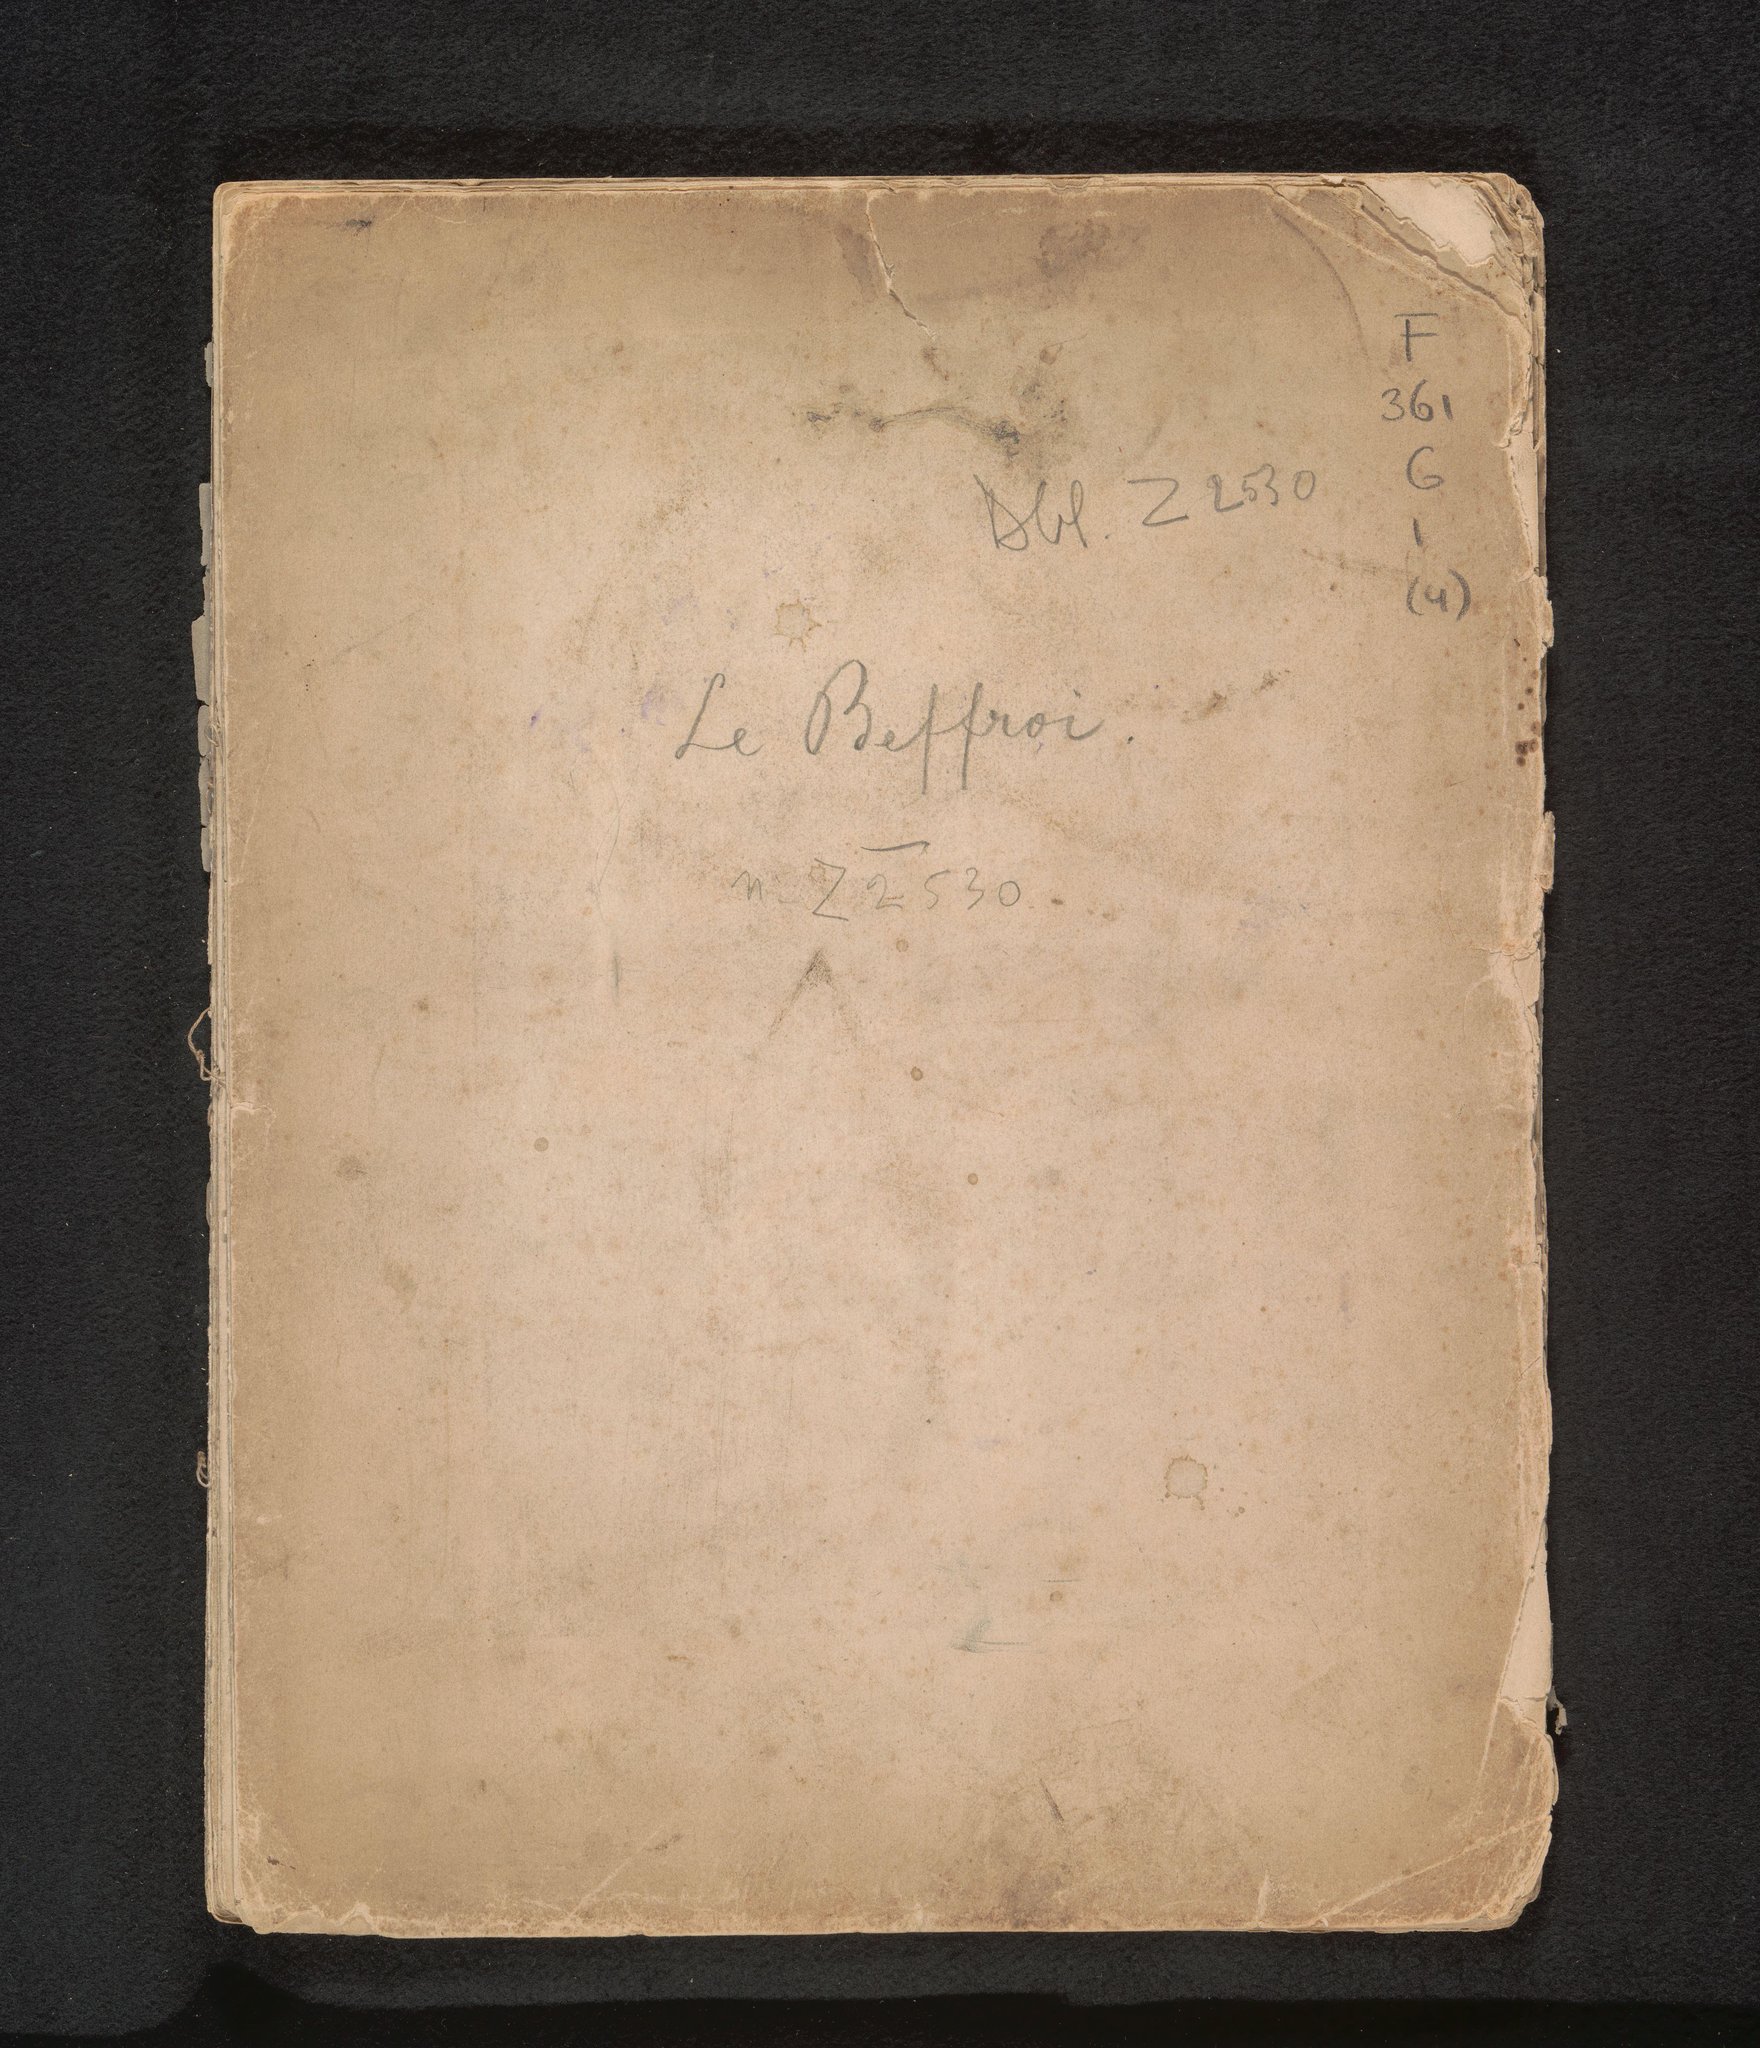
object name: book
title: Le beffroi : arts, héraldique, archéologie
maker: edward gailliard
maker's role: publisher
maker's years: 1841-1922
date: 1864-1865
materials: paper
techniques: photolithography, printing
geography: bruges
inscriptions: annotation: ‘Dbl. ZL530’, title: ‘Le Beffroi’, annotation: ‘n: Z2 530’